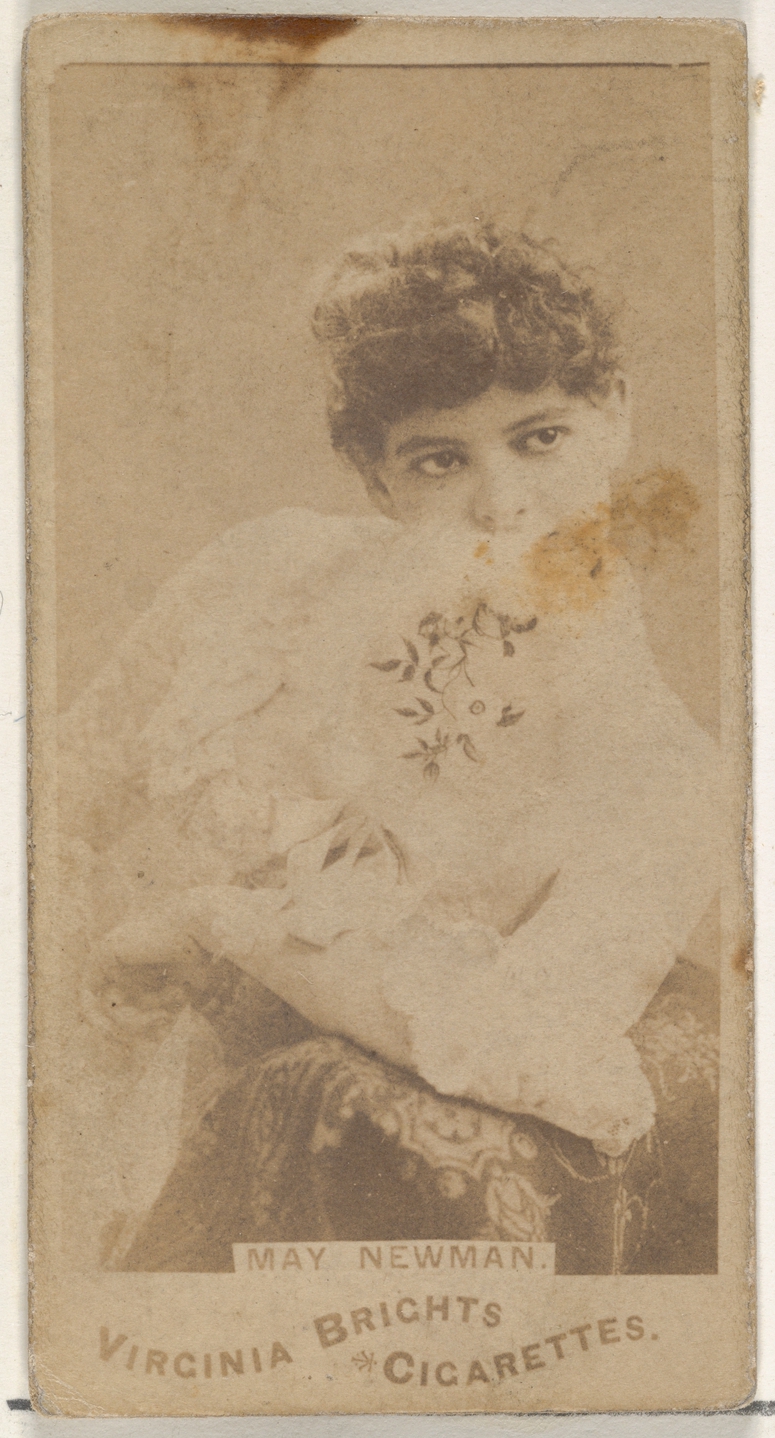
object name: photograph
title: May Newman, from the Actors and Actresses series (N45, Type 1) for Virginia Brights Cigarettes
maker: allen & ginter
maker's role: publisher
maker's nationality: american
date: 1888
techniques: albumen silver print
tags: portraits,women,actresses